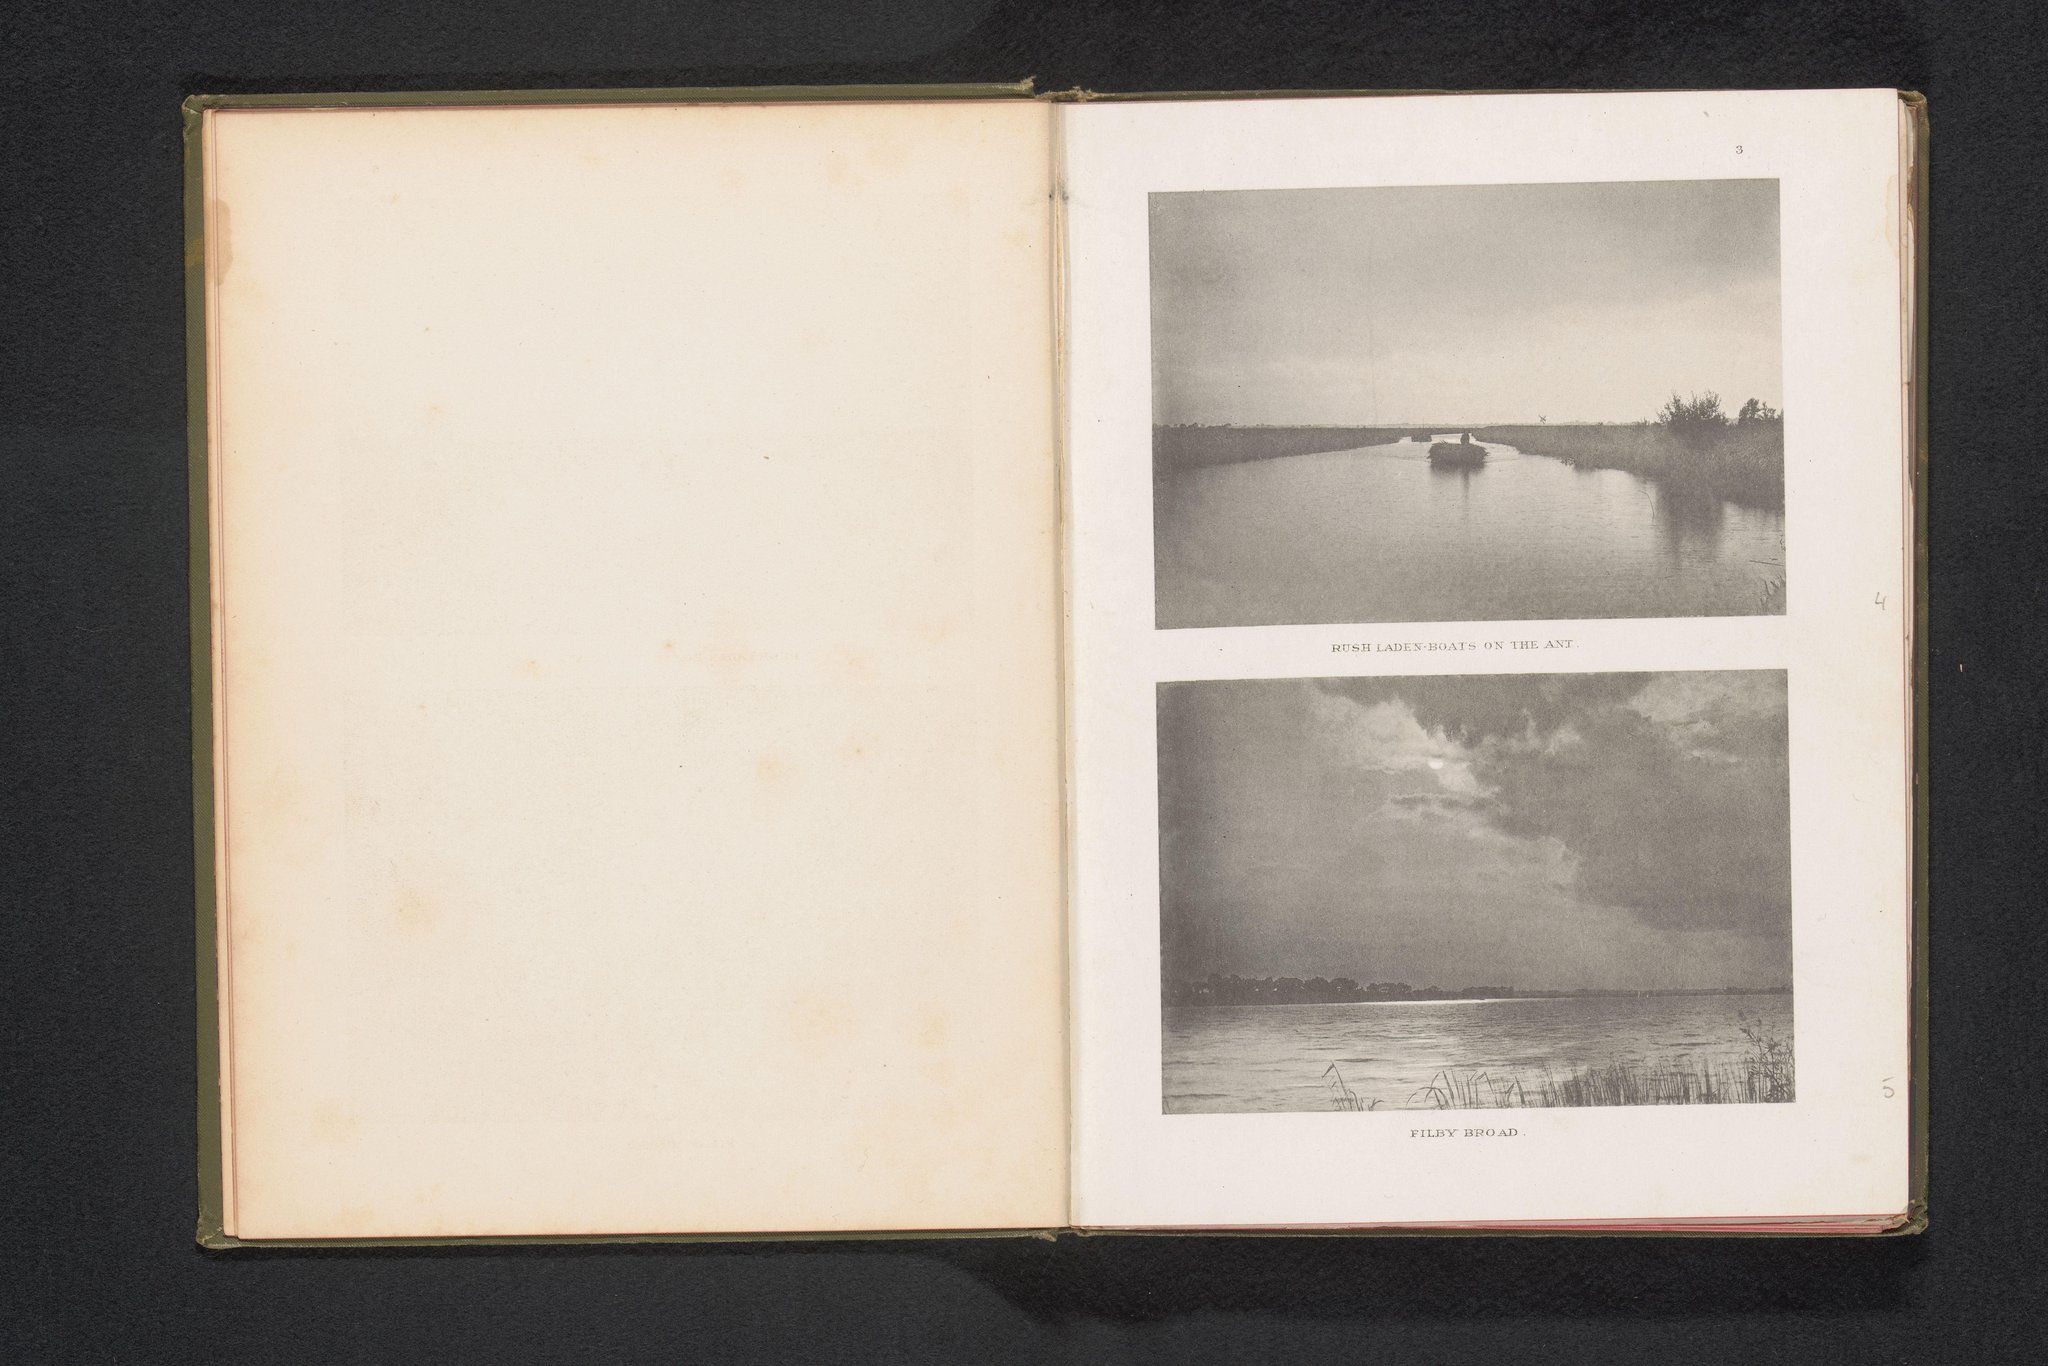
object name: photomechanical print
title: Gezicht op een meer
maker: john payne jennings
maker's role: fotograaf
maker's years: 1843-1926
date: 1886-1891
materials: paper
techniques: photograph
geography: surrey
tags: landscapes with waters, waterscapes, seascapes (in the temperate zone), lake